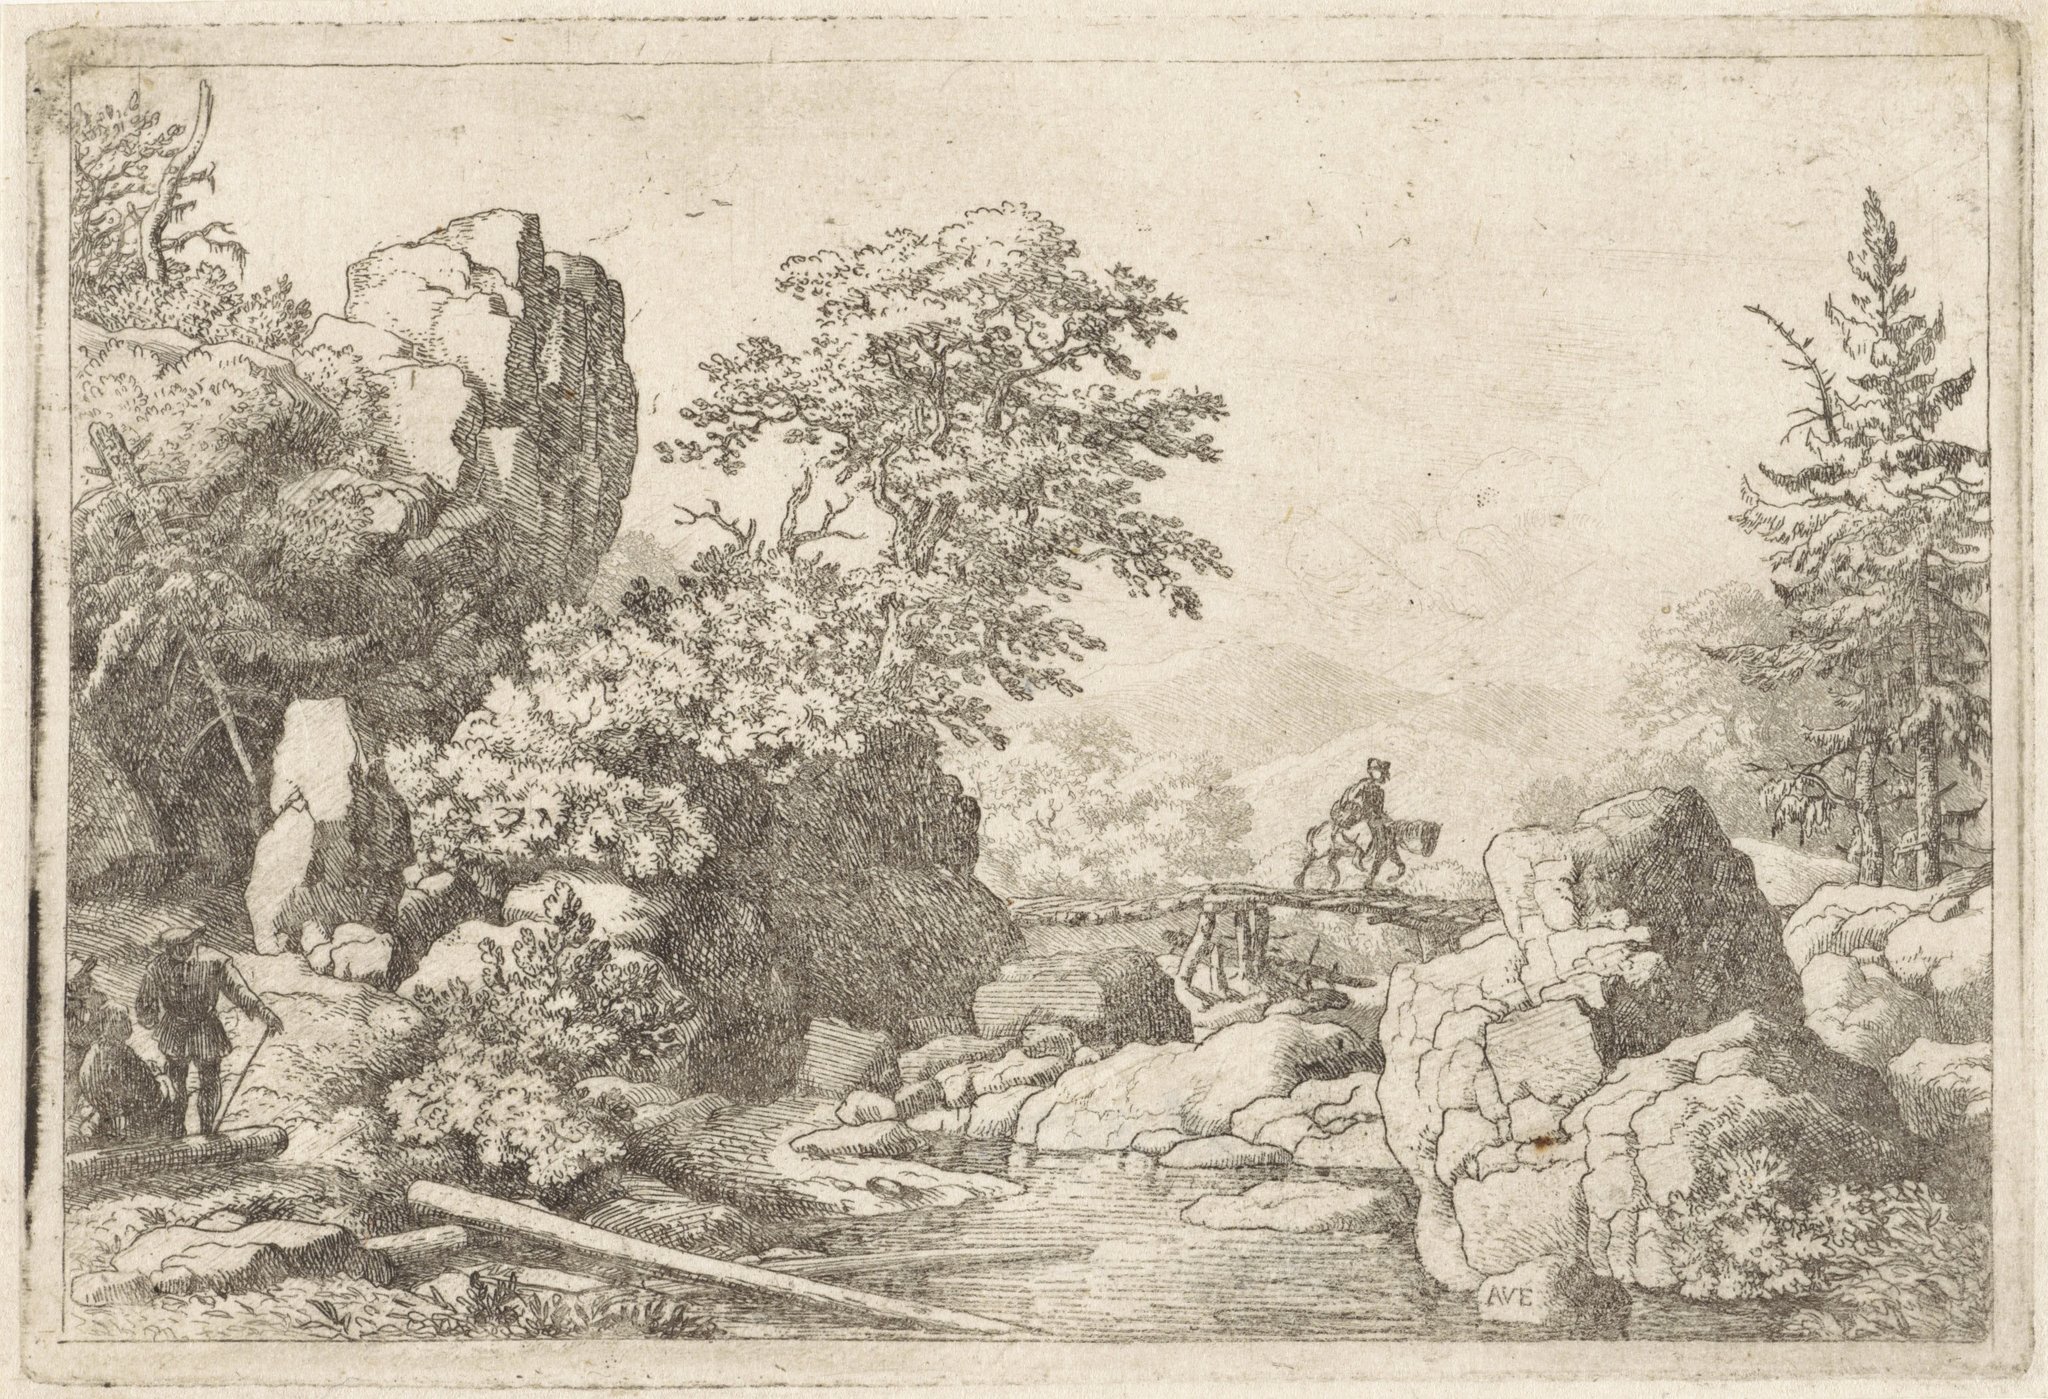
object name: print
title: Landschap met ruiter op brug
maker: allaert van everdingen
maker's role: draughtsman, painter, print maker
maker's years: 1621-1675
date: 1631-1675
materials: paper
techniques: etching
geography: netherlands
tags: riding a horse, ass, or mule; rider, horseman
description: Rotslandschap met op de brug over een slingerende beek een man op een paard. Op de oever bij een boomstam drie personen.